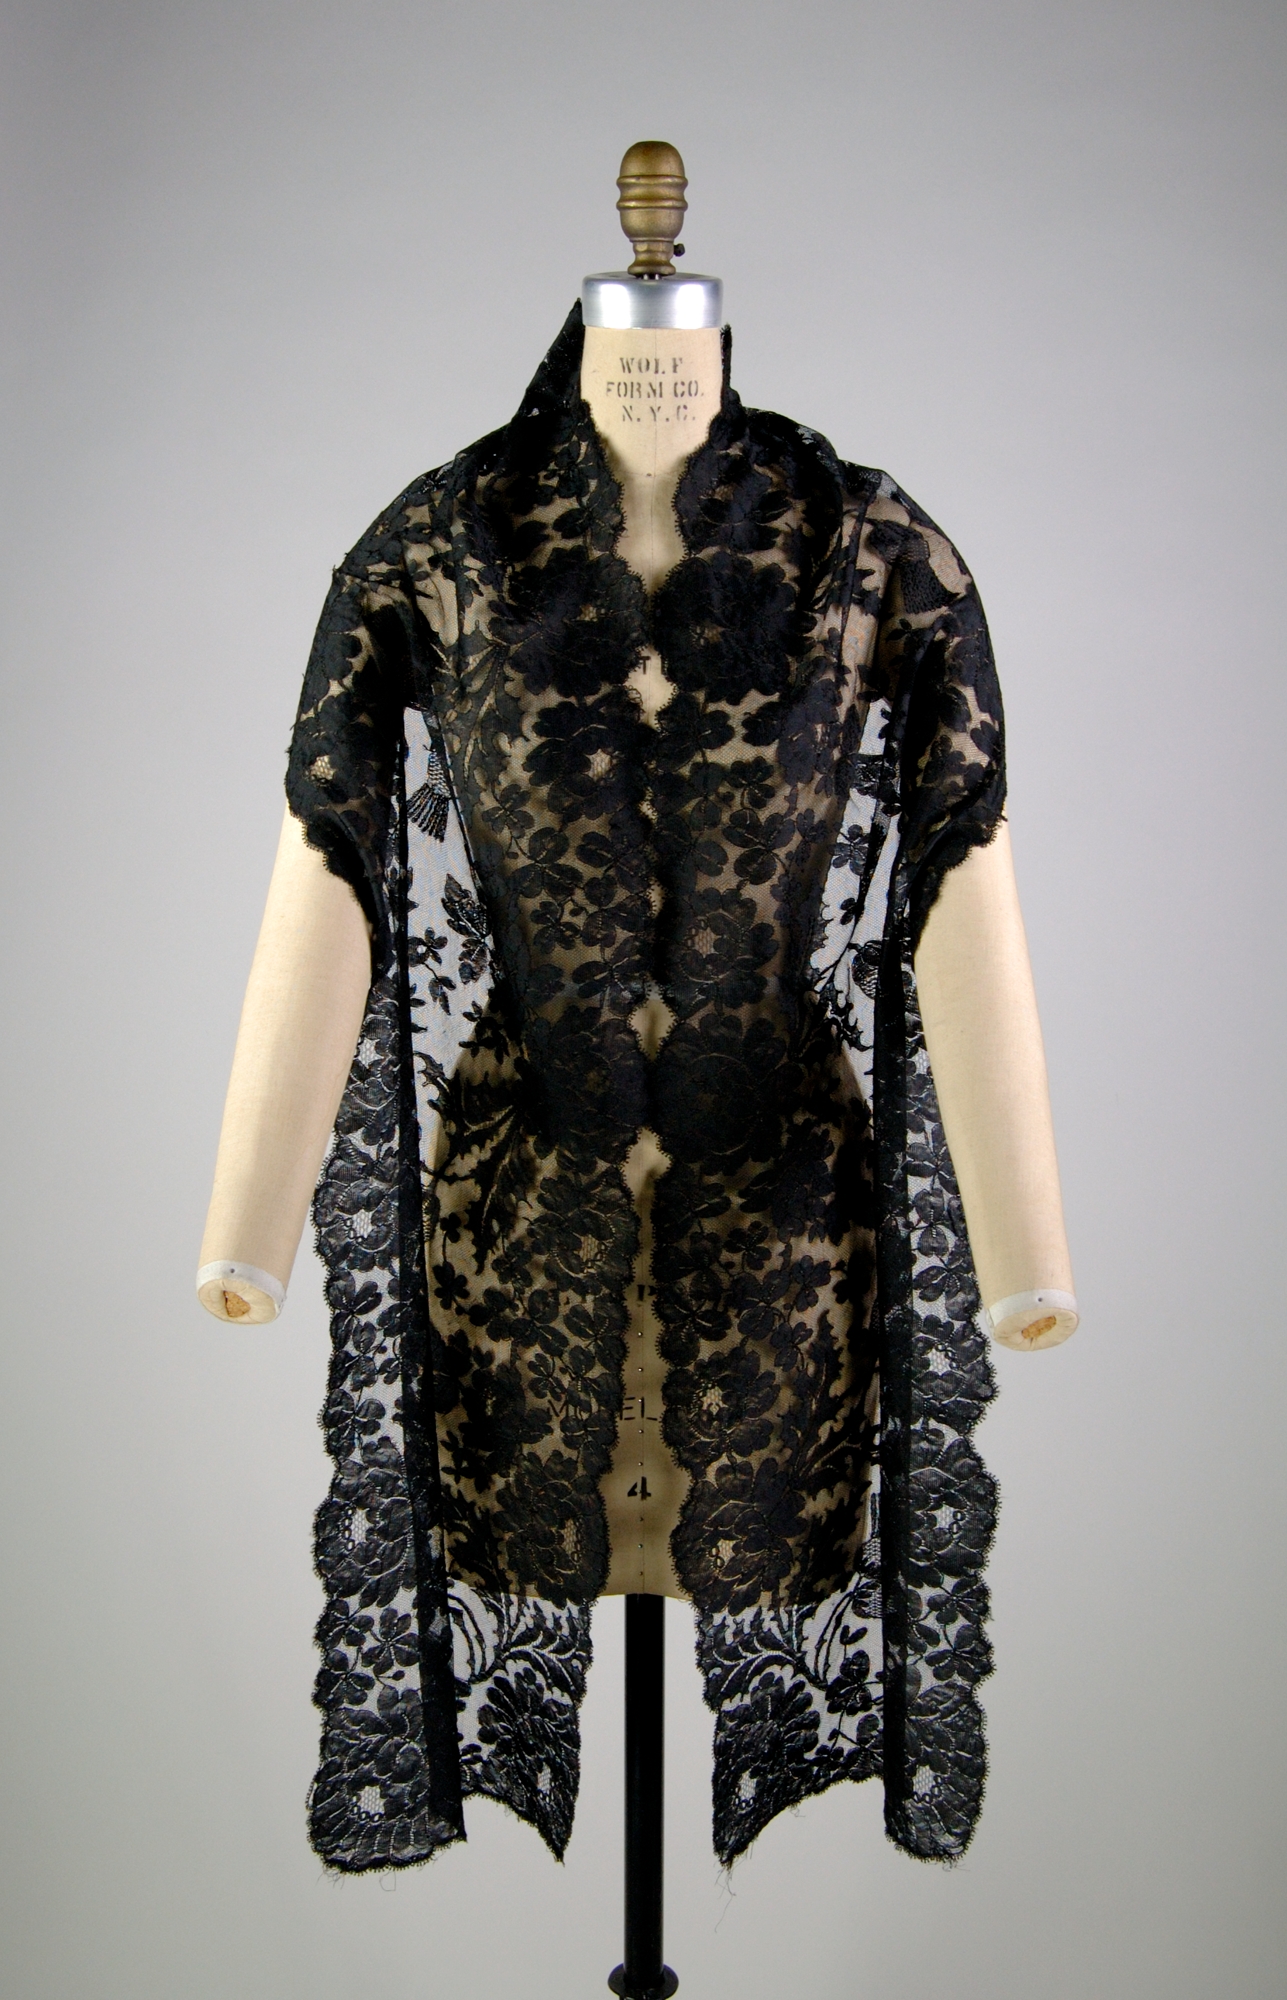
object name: stole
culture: spanish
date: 1876-1900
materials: silk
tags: flowers